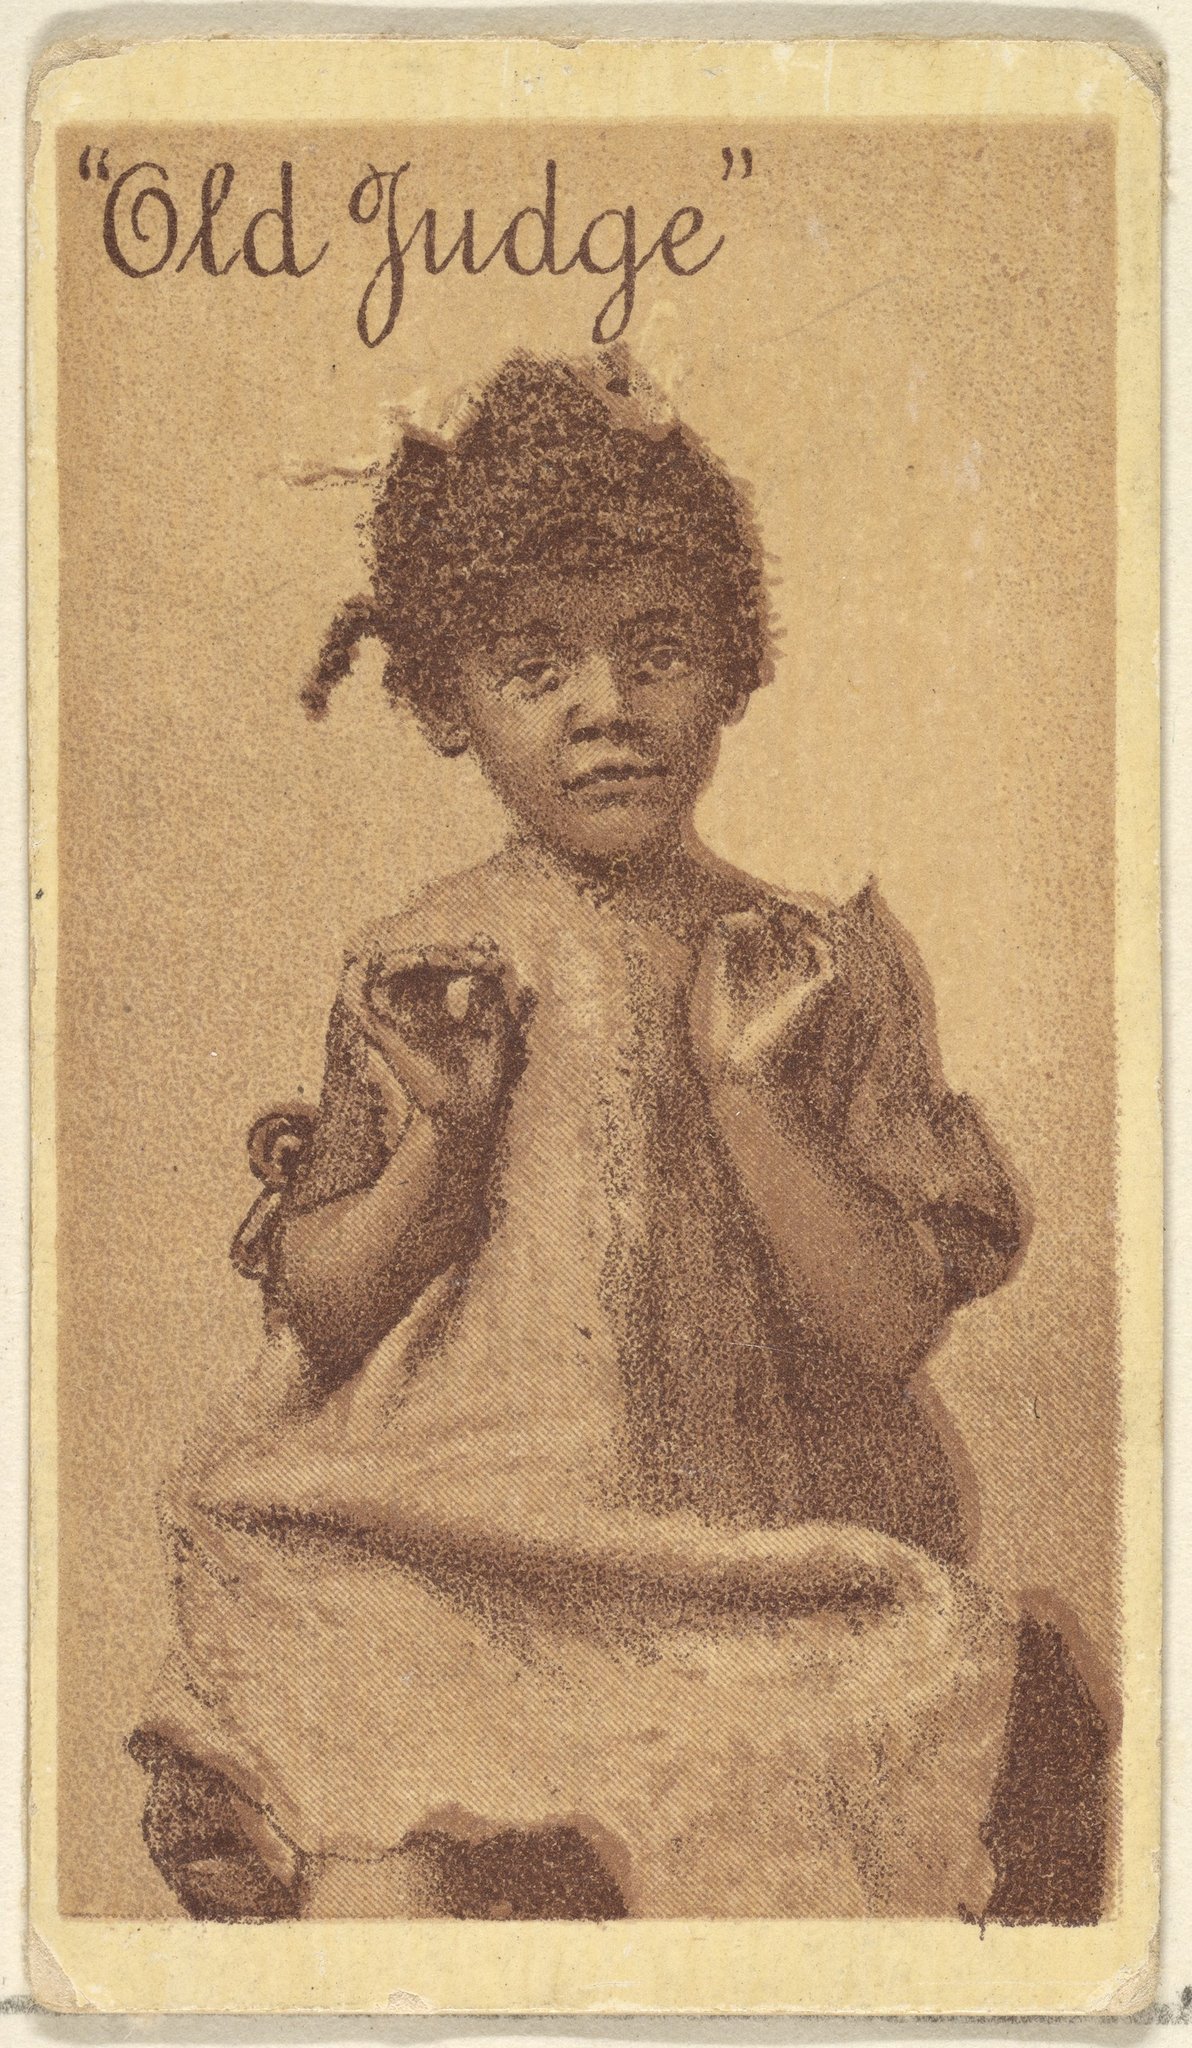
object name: print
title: From the Old Judge series (N167) for Old Judge Cigarettes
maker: goodwin & company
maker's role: publisher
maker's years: 1850-1950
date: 1886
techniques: lithography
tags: girls,portraits